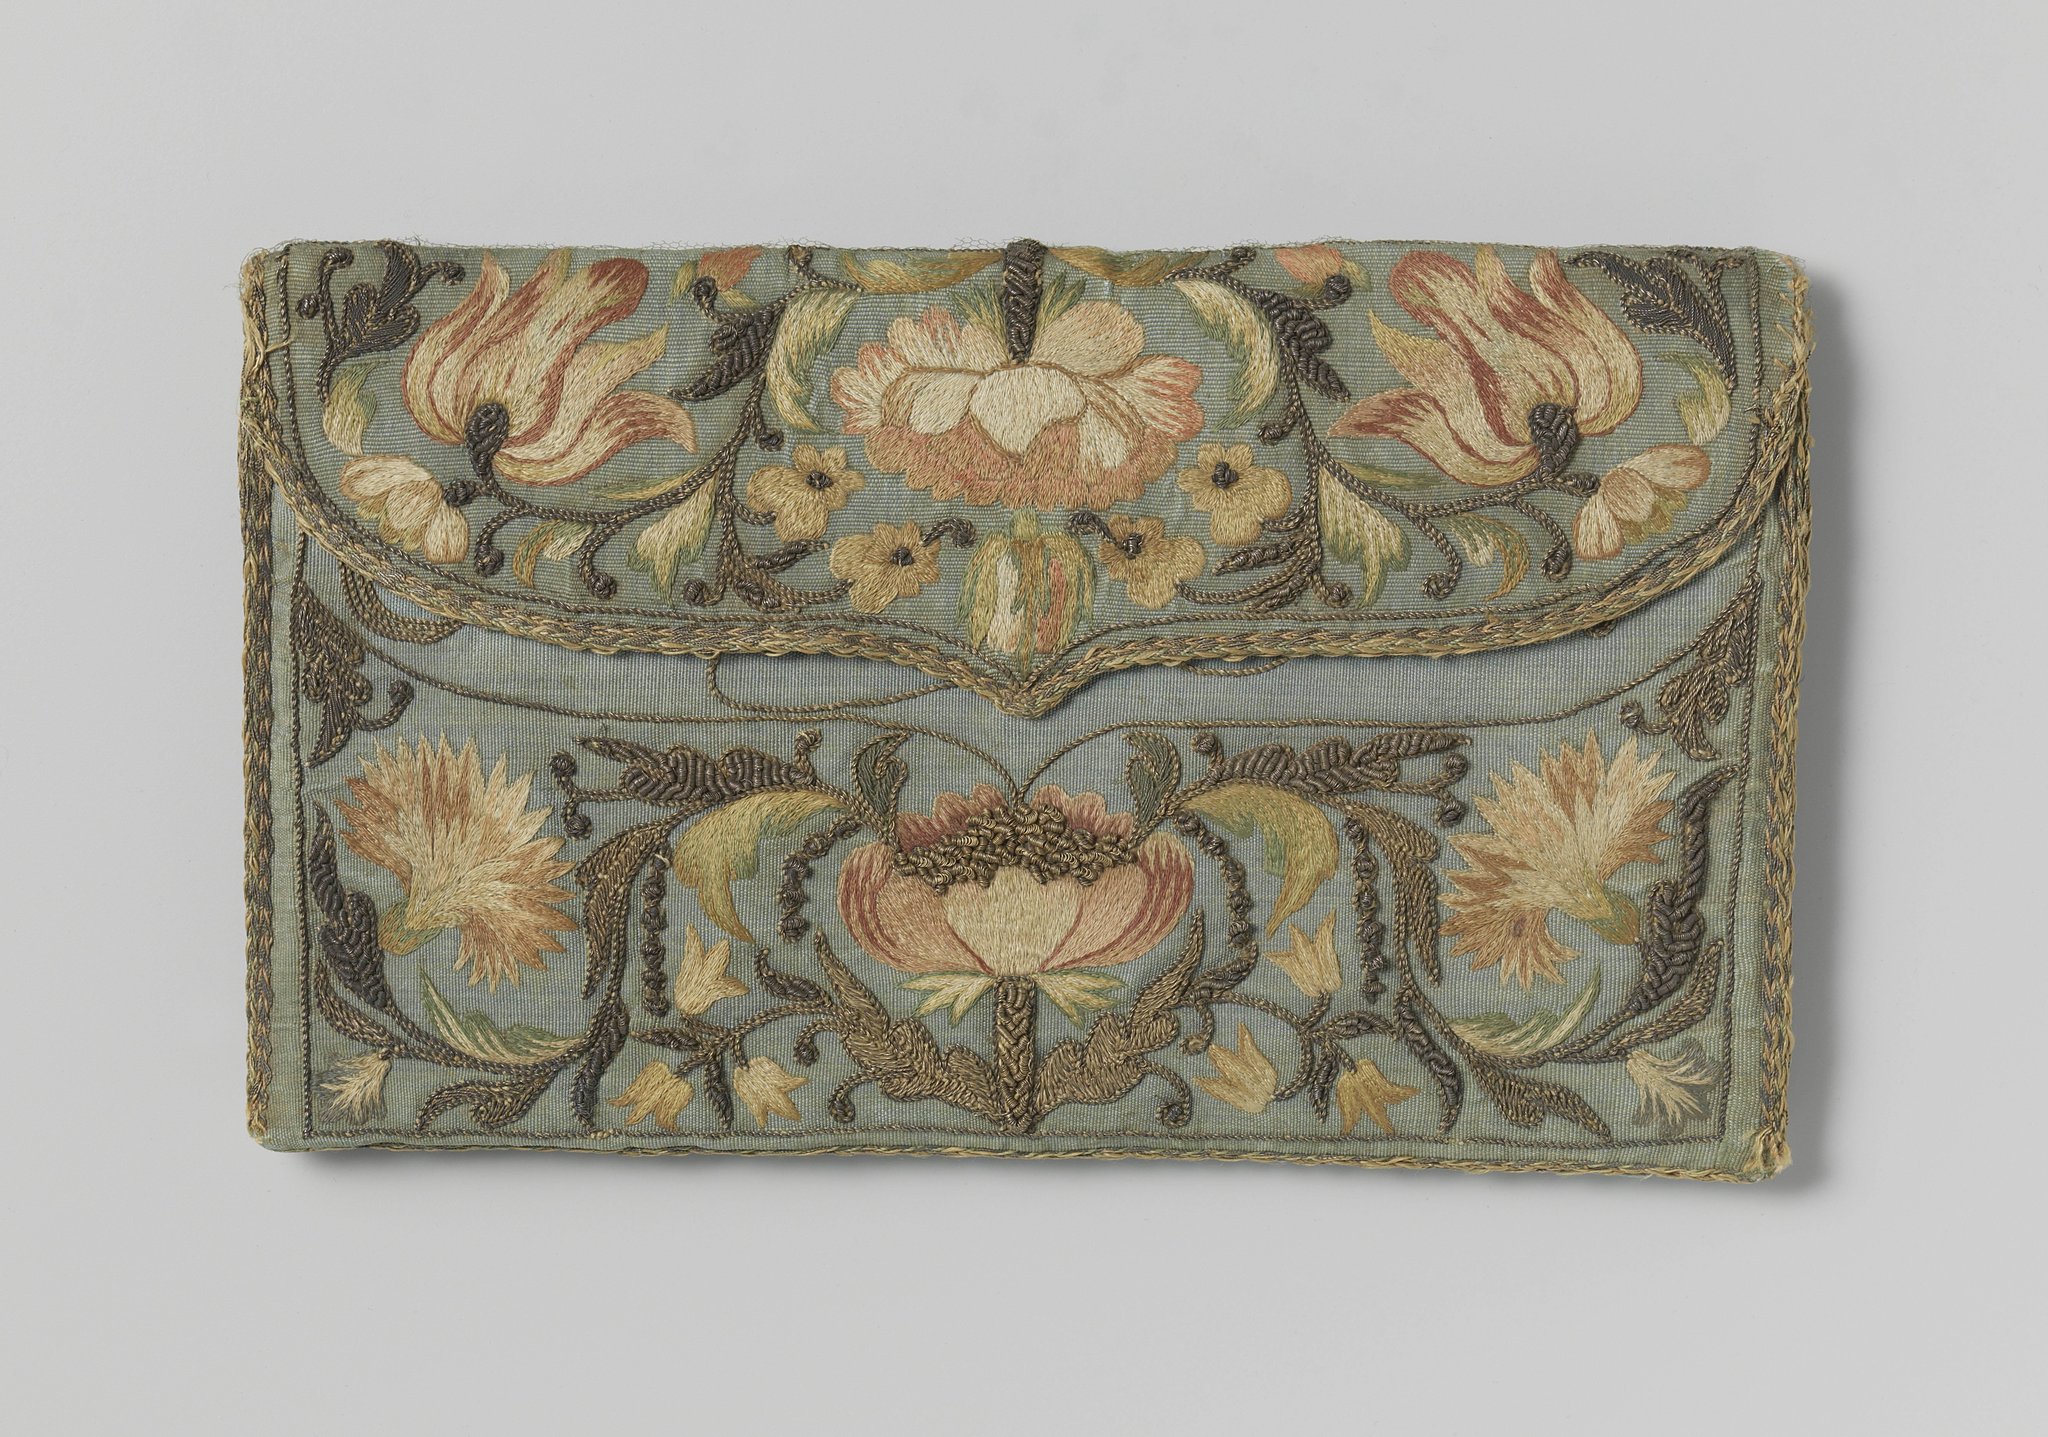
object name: brieventas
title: Blue letter case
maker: Anonymous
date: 1728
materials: gold thread, silk, thread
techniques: embroidered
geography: istanbul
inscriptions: : ‘Constantinopoli 1728’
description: Brieventas (portefeuille) met verschillende soorten geborduurde gekleurde bloemen op een blauw fond. Aan de achterzijde staat 'Constantinopoli 1728'.